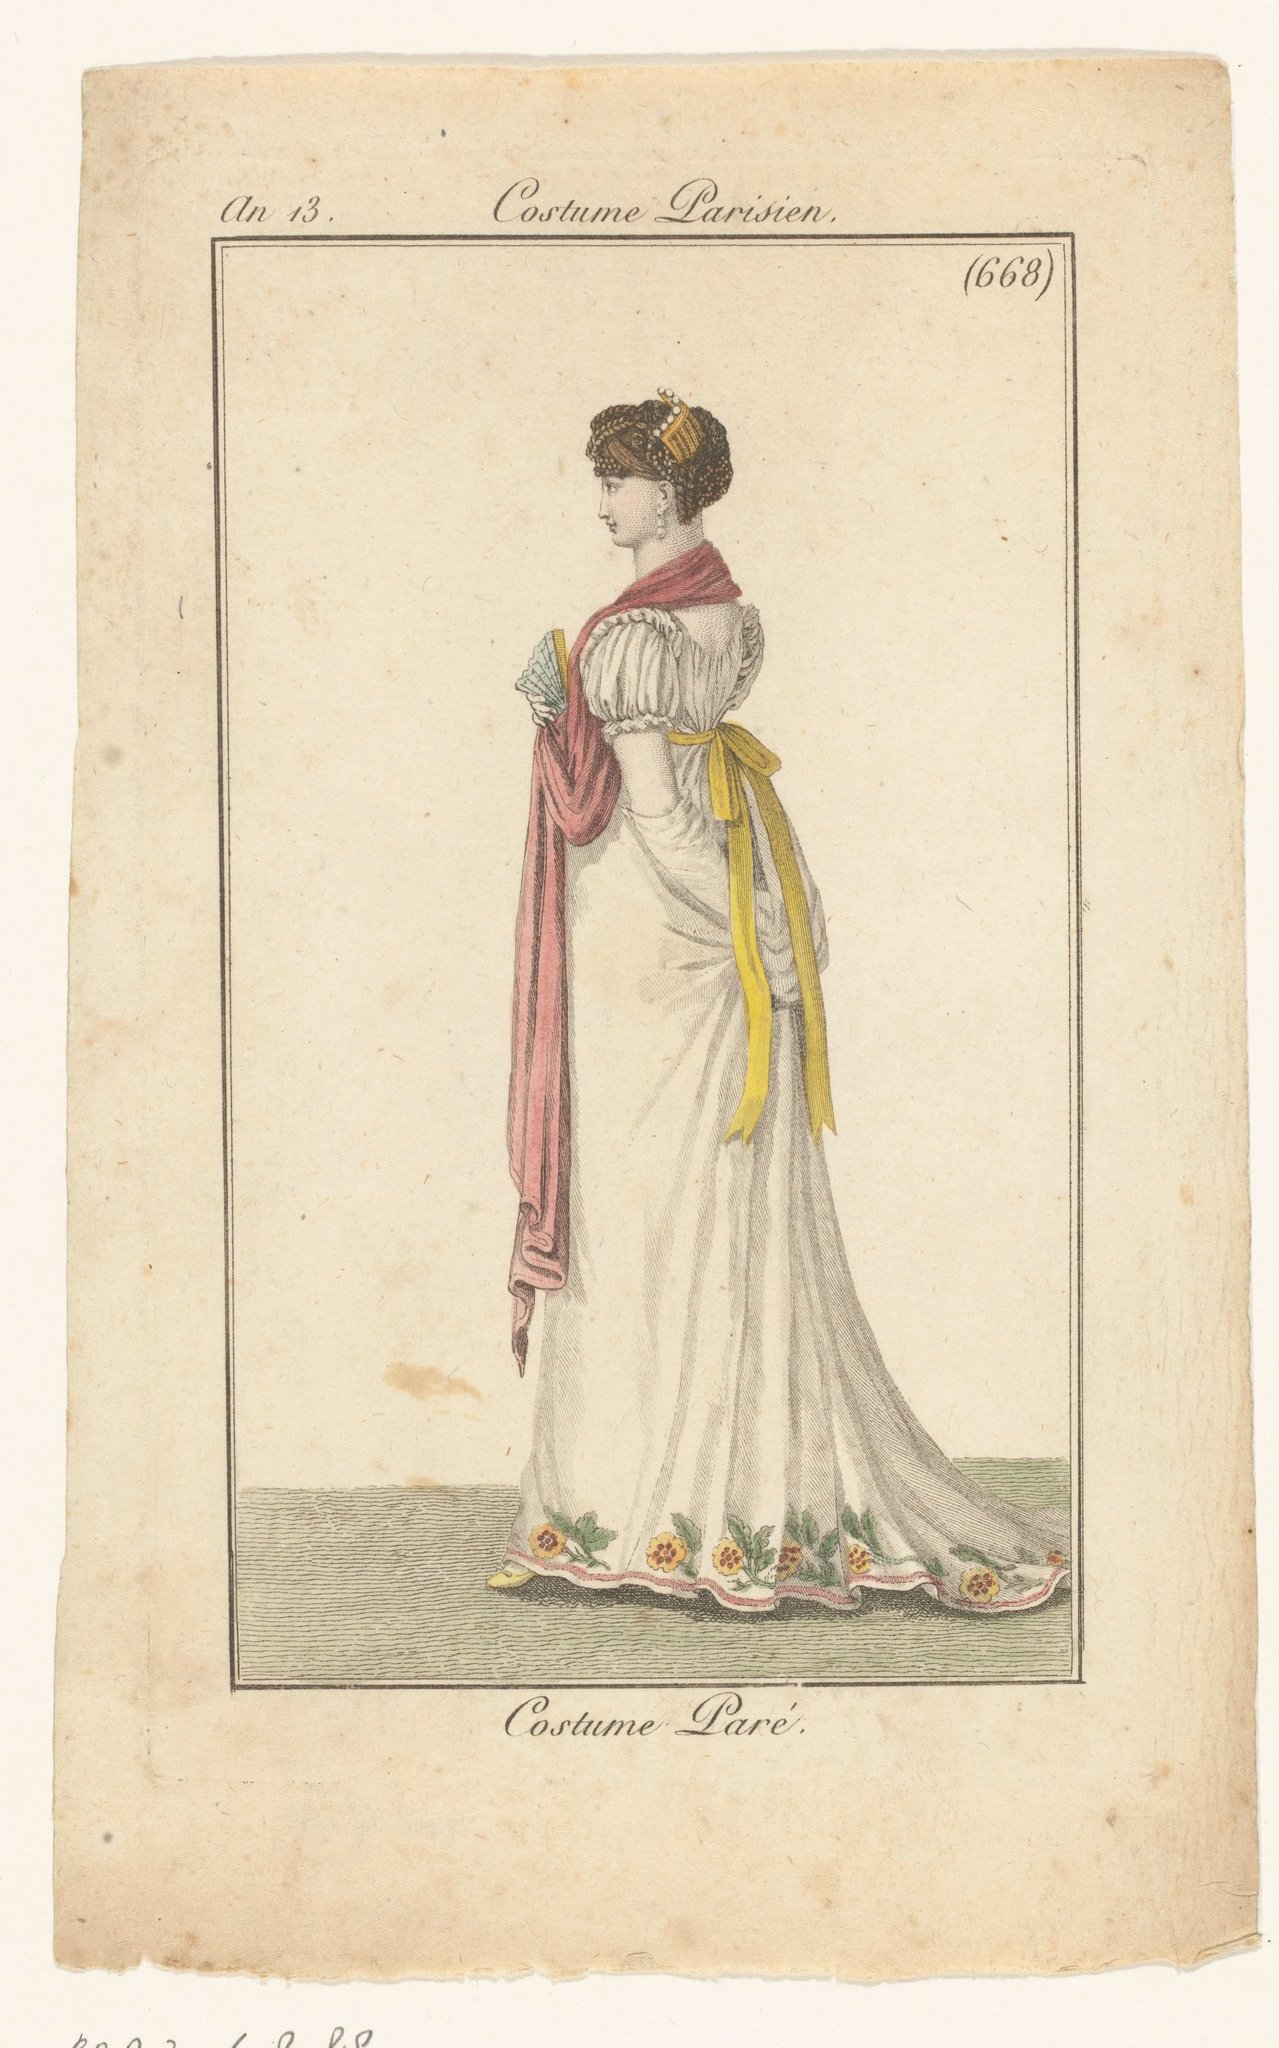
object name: fashion print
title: Journal des Dames et des modes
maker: Anonymous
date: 1804-1805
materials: paper, ink, watercolor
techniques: etching, hand coloring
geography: france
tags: fashion plates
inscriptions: collector's mark: Lugt 2228